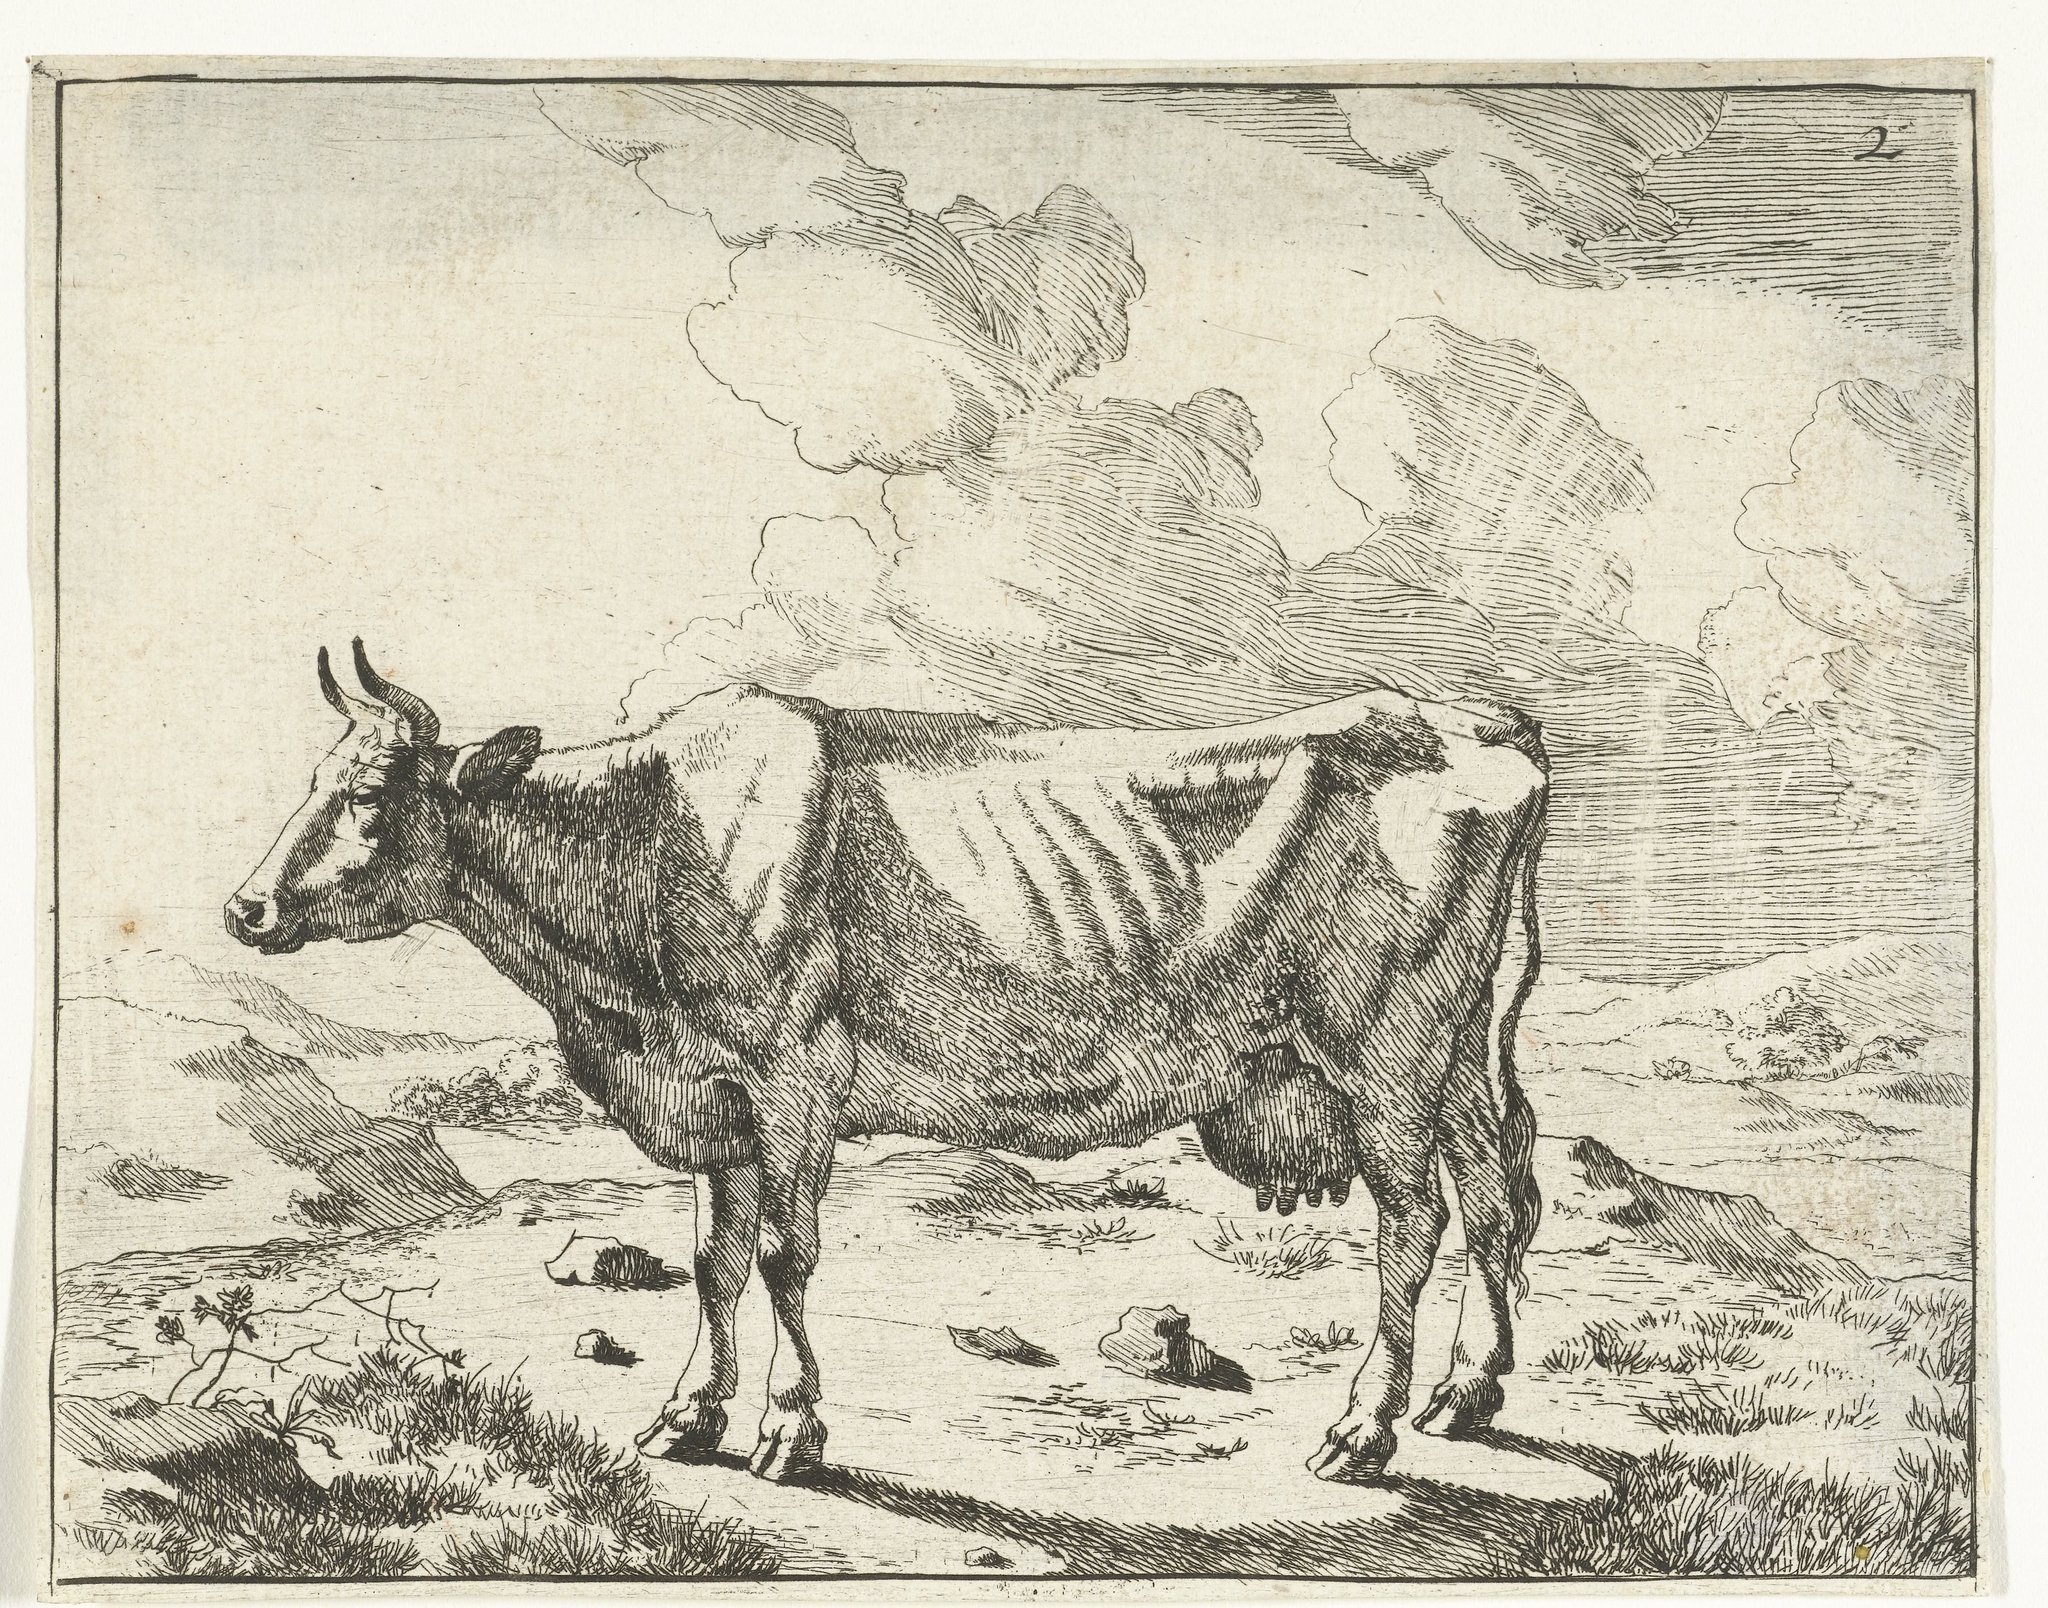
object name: print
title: Koeien en stieren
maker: marcus de bye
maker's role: print maker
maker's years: 1639-1688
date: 1657-1677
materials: paper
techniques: etching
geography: the hague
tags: cow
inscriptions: collector's mark: Lugt 240, collector's mark: Lugt 1337